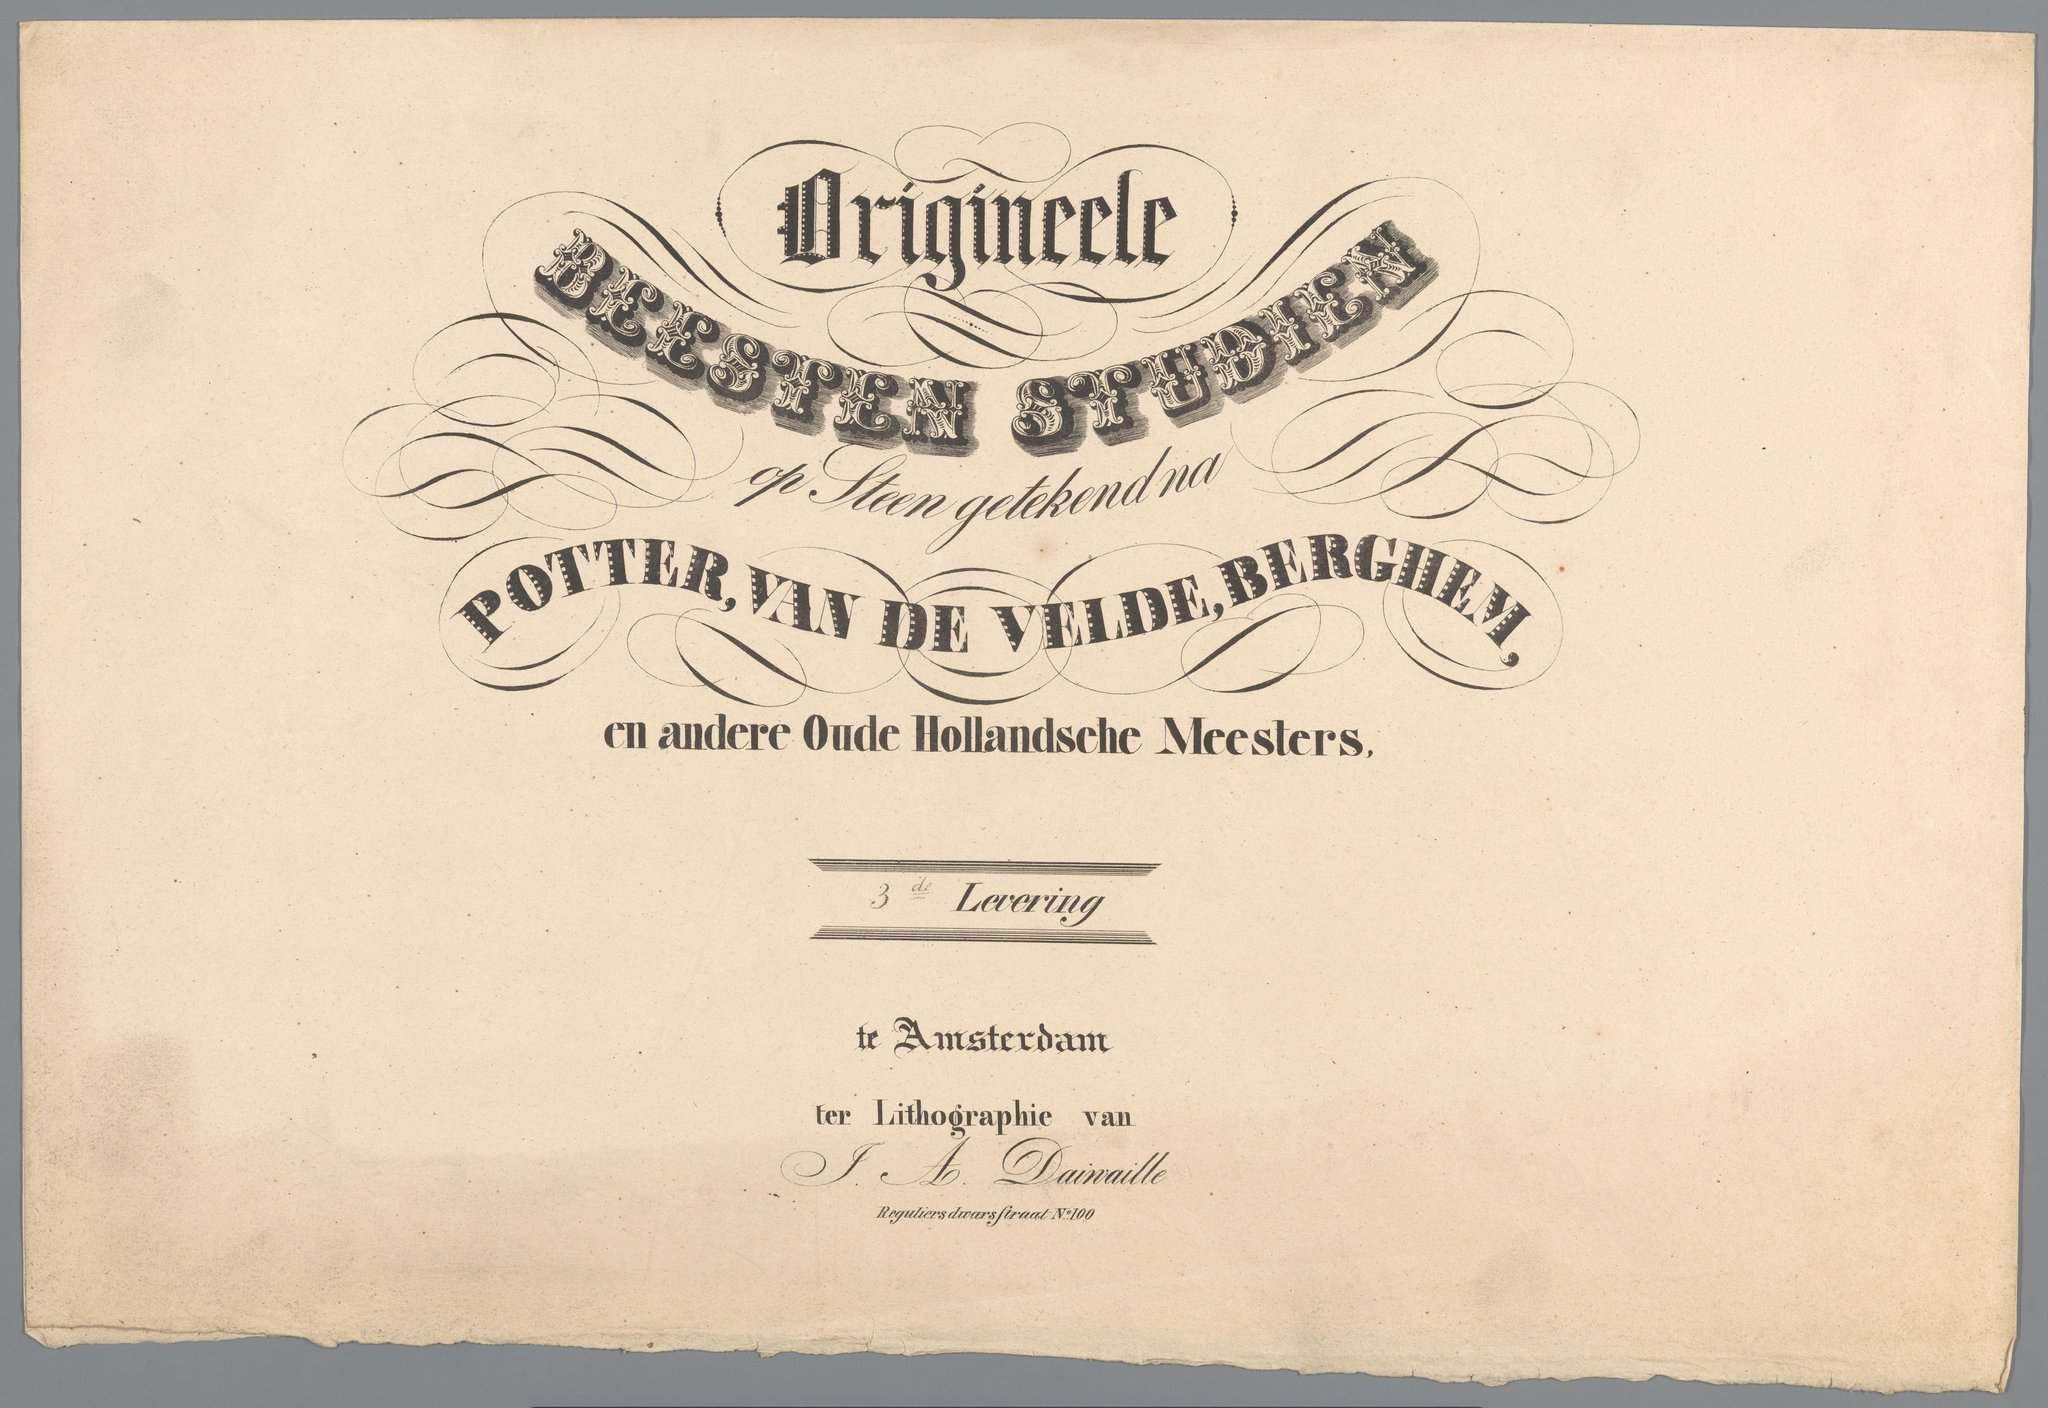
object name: print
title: Omslag voor Origineele Beesten Studien op Steen getekend na Potter, Van de Velde, Berghem, en andere Oude Hollandsche Meesters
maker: jean augustin daiwaille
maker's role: draughtsman, print maker, printer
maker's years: 1786-1850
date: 1820-1833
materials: paper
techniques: lithograph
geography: amsterdam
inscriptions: inscription: ‘3de’, collector's mark: Lugt 2228